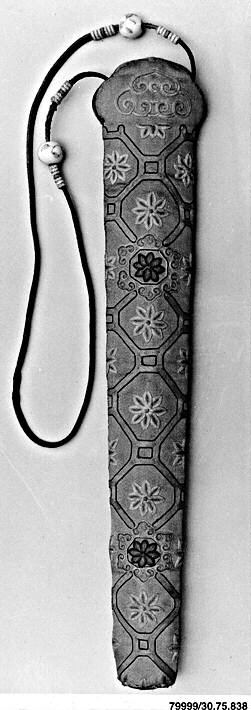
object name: fan holder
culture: chinese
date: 1701-1900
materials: silk